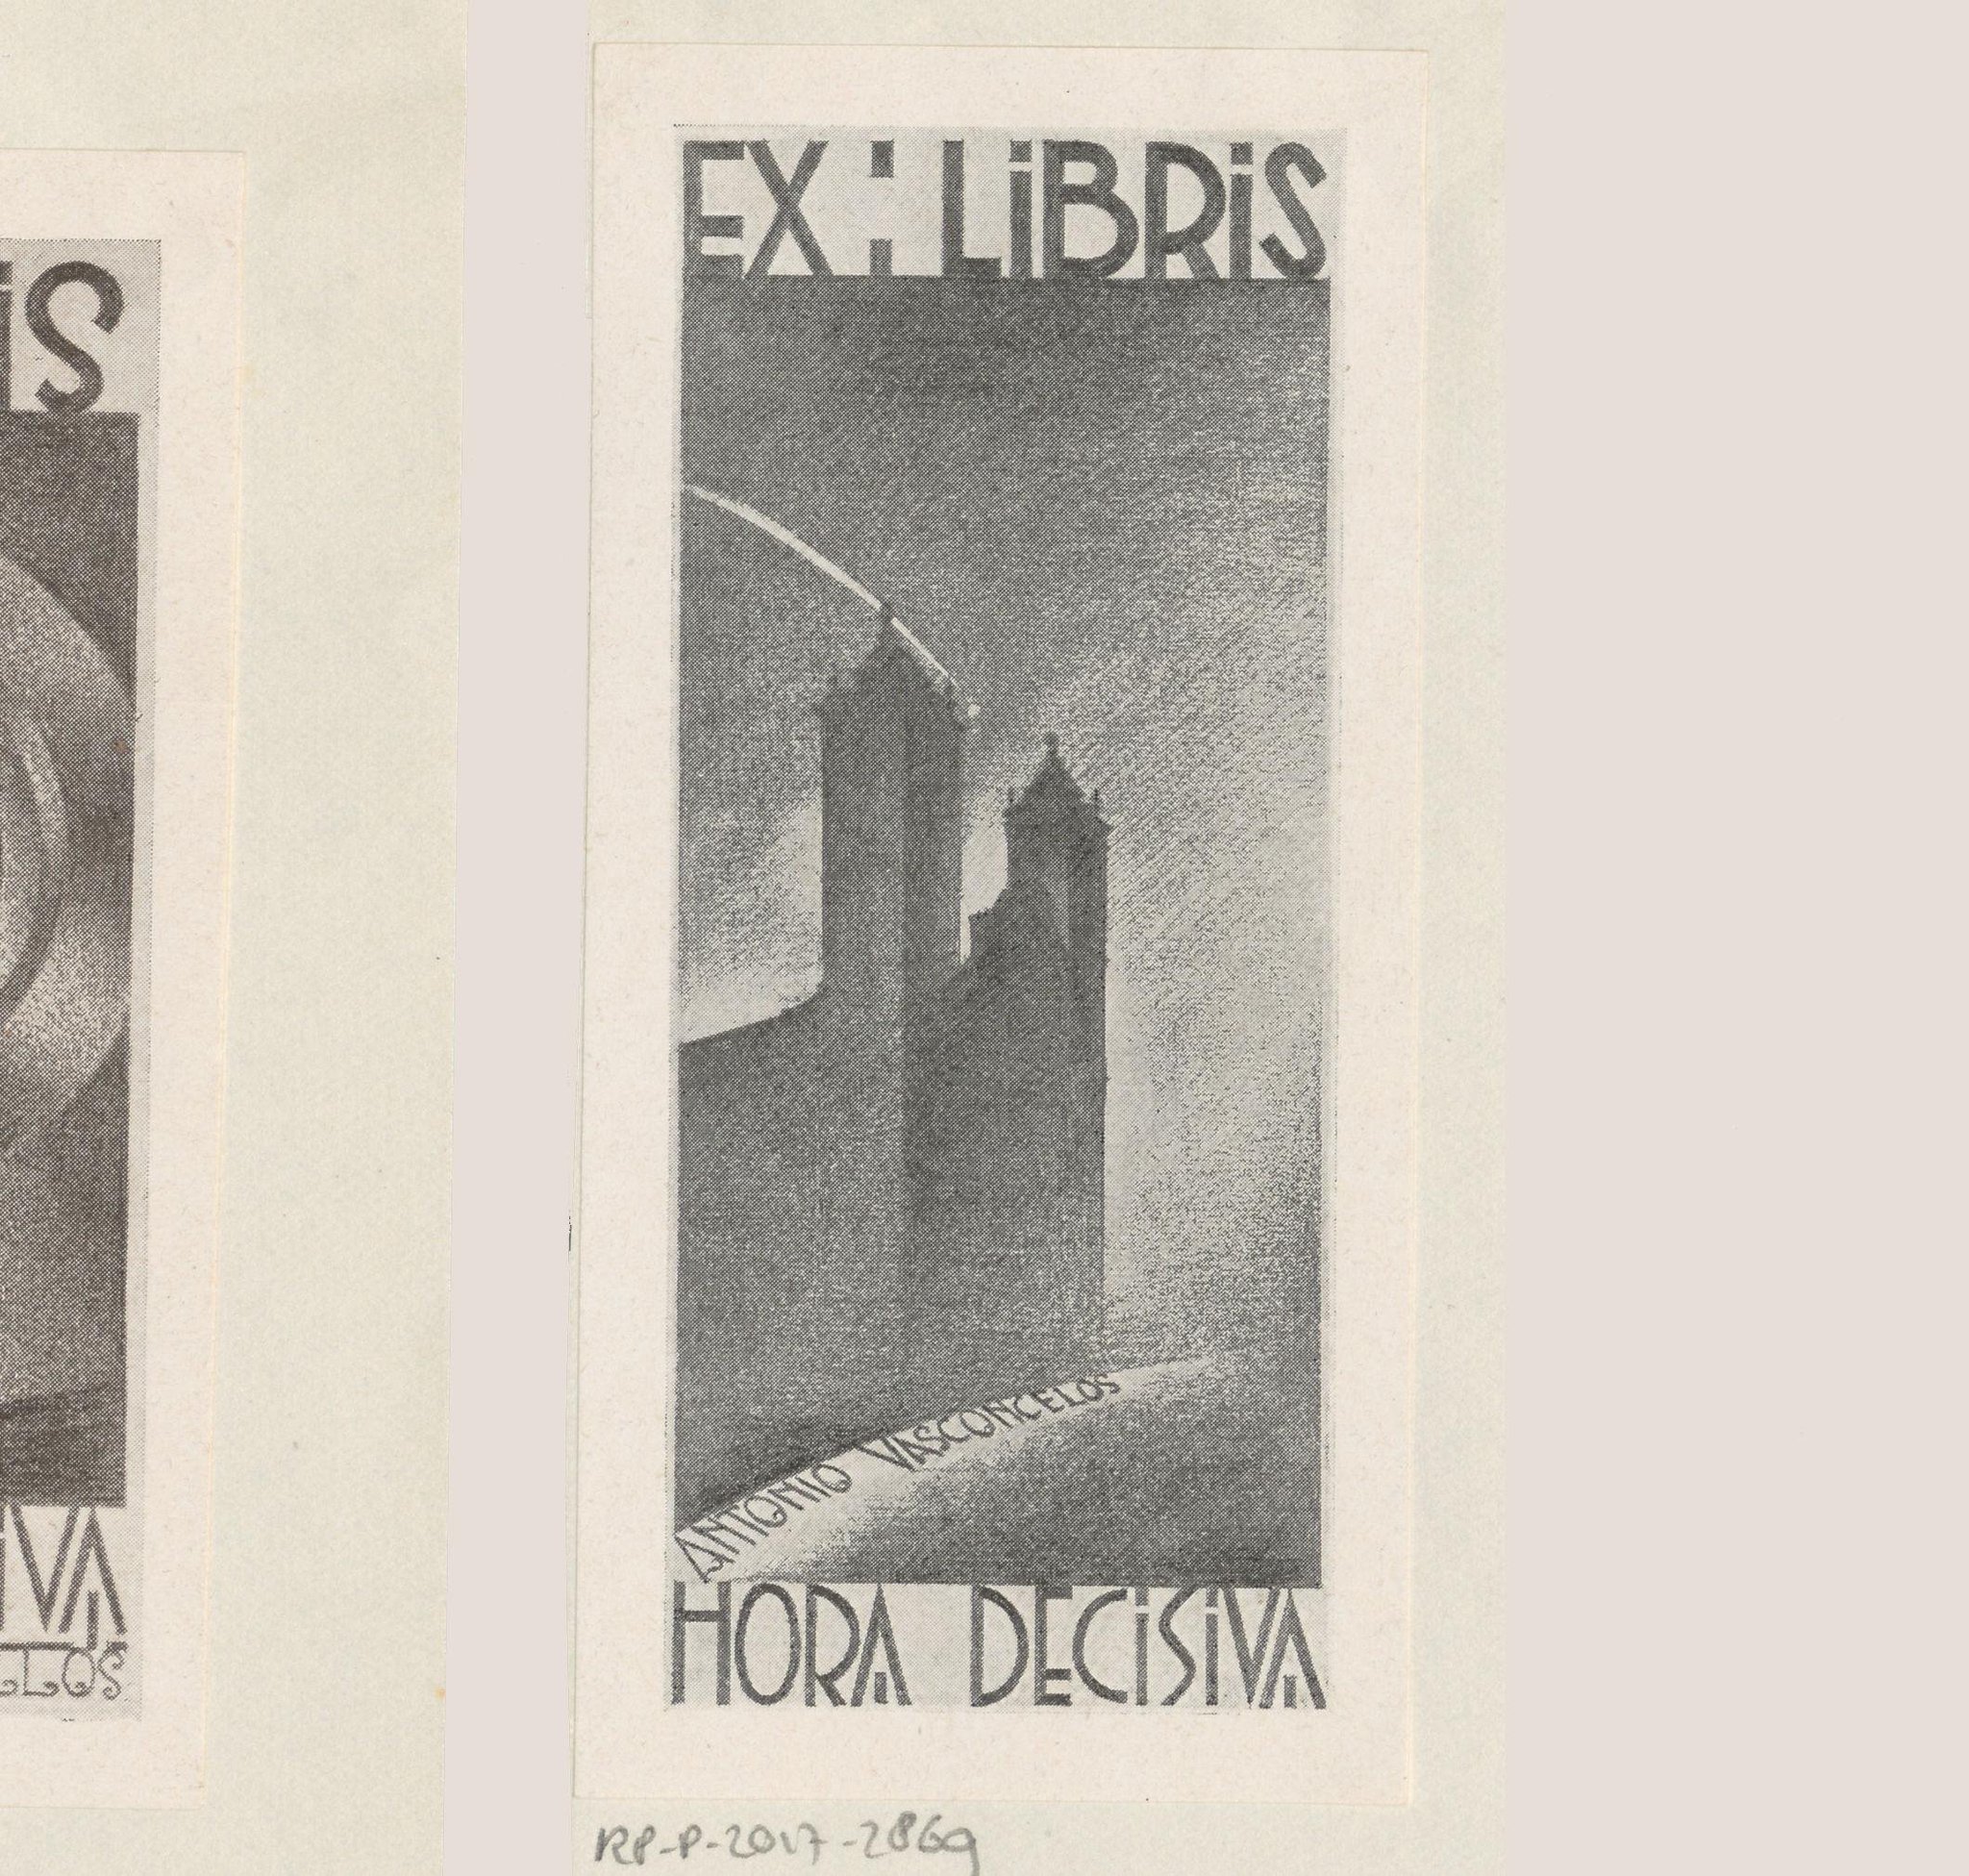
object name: bookplate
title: Ex libris van Antonio Vasconcelos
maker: Anonymous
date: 1900-1999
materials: paper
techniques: autotype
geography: portugal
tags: castle, comet